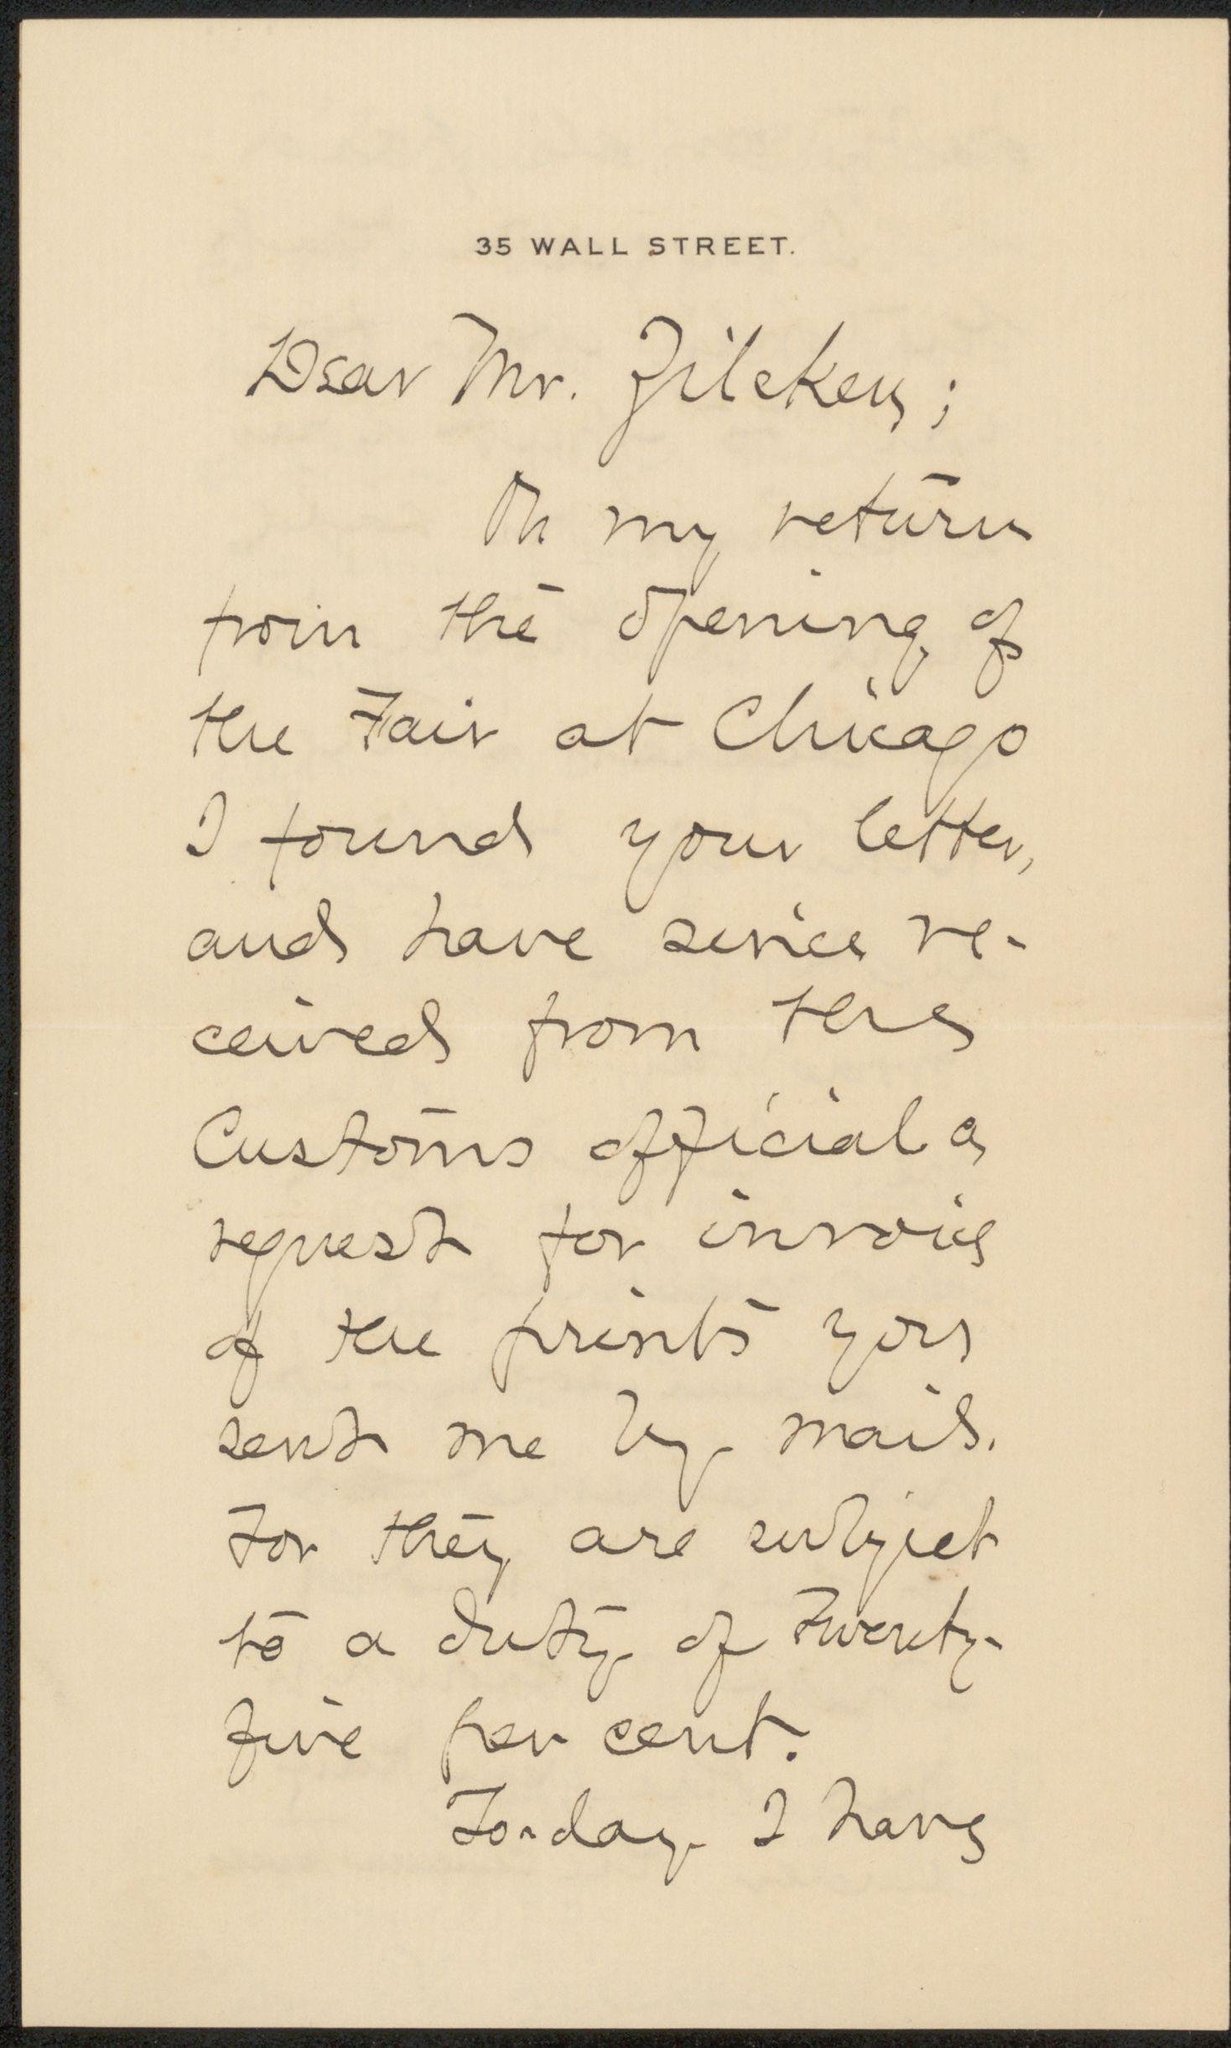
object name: letter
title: Brief aan Philip Zilcken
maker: howard mansfield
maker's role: jurist, verzamelaar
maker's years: 1849-1932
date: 1893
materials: ink, paper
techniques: pen, printing, writing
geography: new york city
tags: frederick keppel, the hague, painter, draughtsman, philip zilcken, art trade, art shop, the graphic arts, painting (including book-illumination, miniature-painting), exhibition ~ art, money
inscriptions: watermark